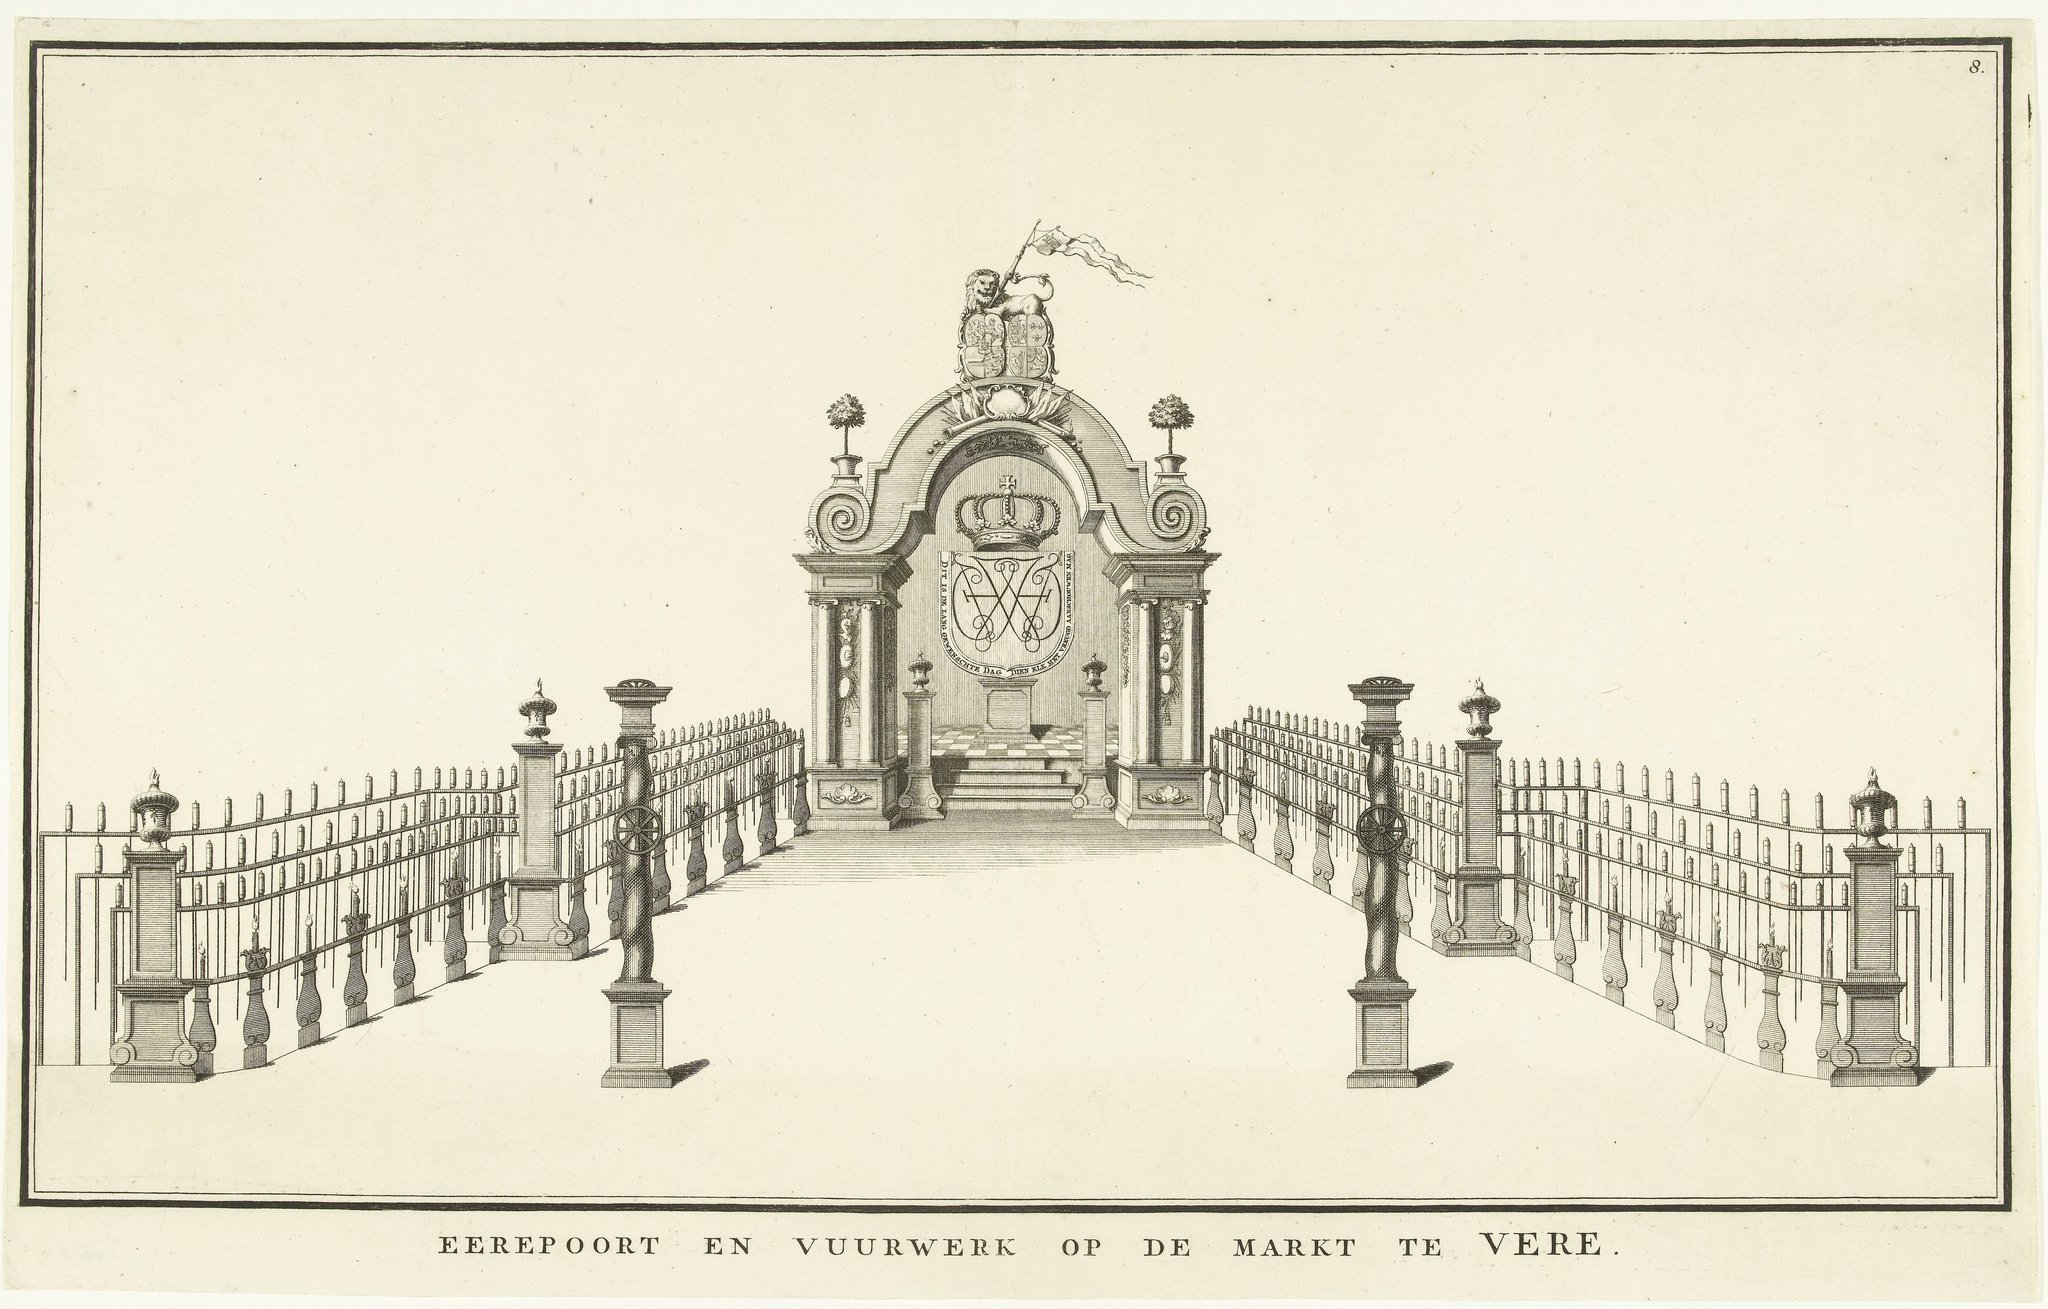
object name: print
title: Eerepoort en vuurwerk op de Markt te Vere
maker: Anonymous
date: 1751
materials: paper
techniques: engraving, etching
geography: northern netherlands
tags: willem iv (prins van oranje-nassau), triumphal arch, bonfire, fire-works (+ illumination, fire-works ~ festive activities)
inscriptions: collector's mark: Lugt 2228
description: De erepoort met het gereedstaande vuurwerk opgesteld op de Markt. Onderdeel van de illustraties van de feestelijke inhuldiging van stadhouder Willem IV als markgraaf van Veere op 1 juni 1751. Genummerd rechtsboven: 8.